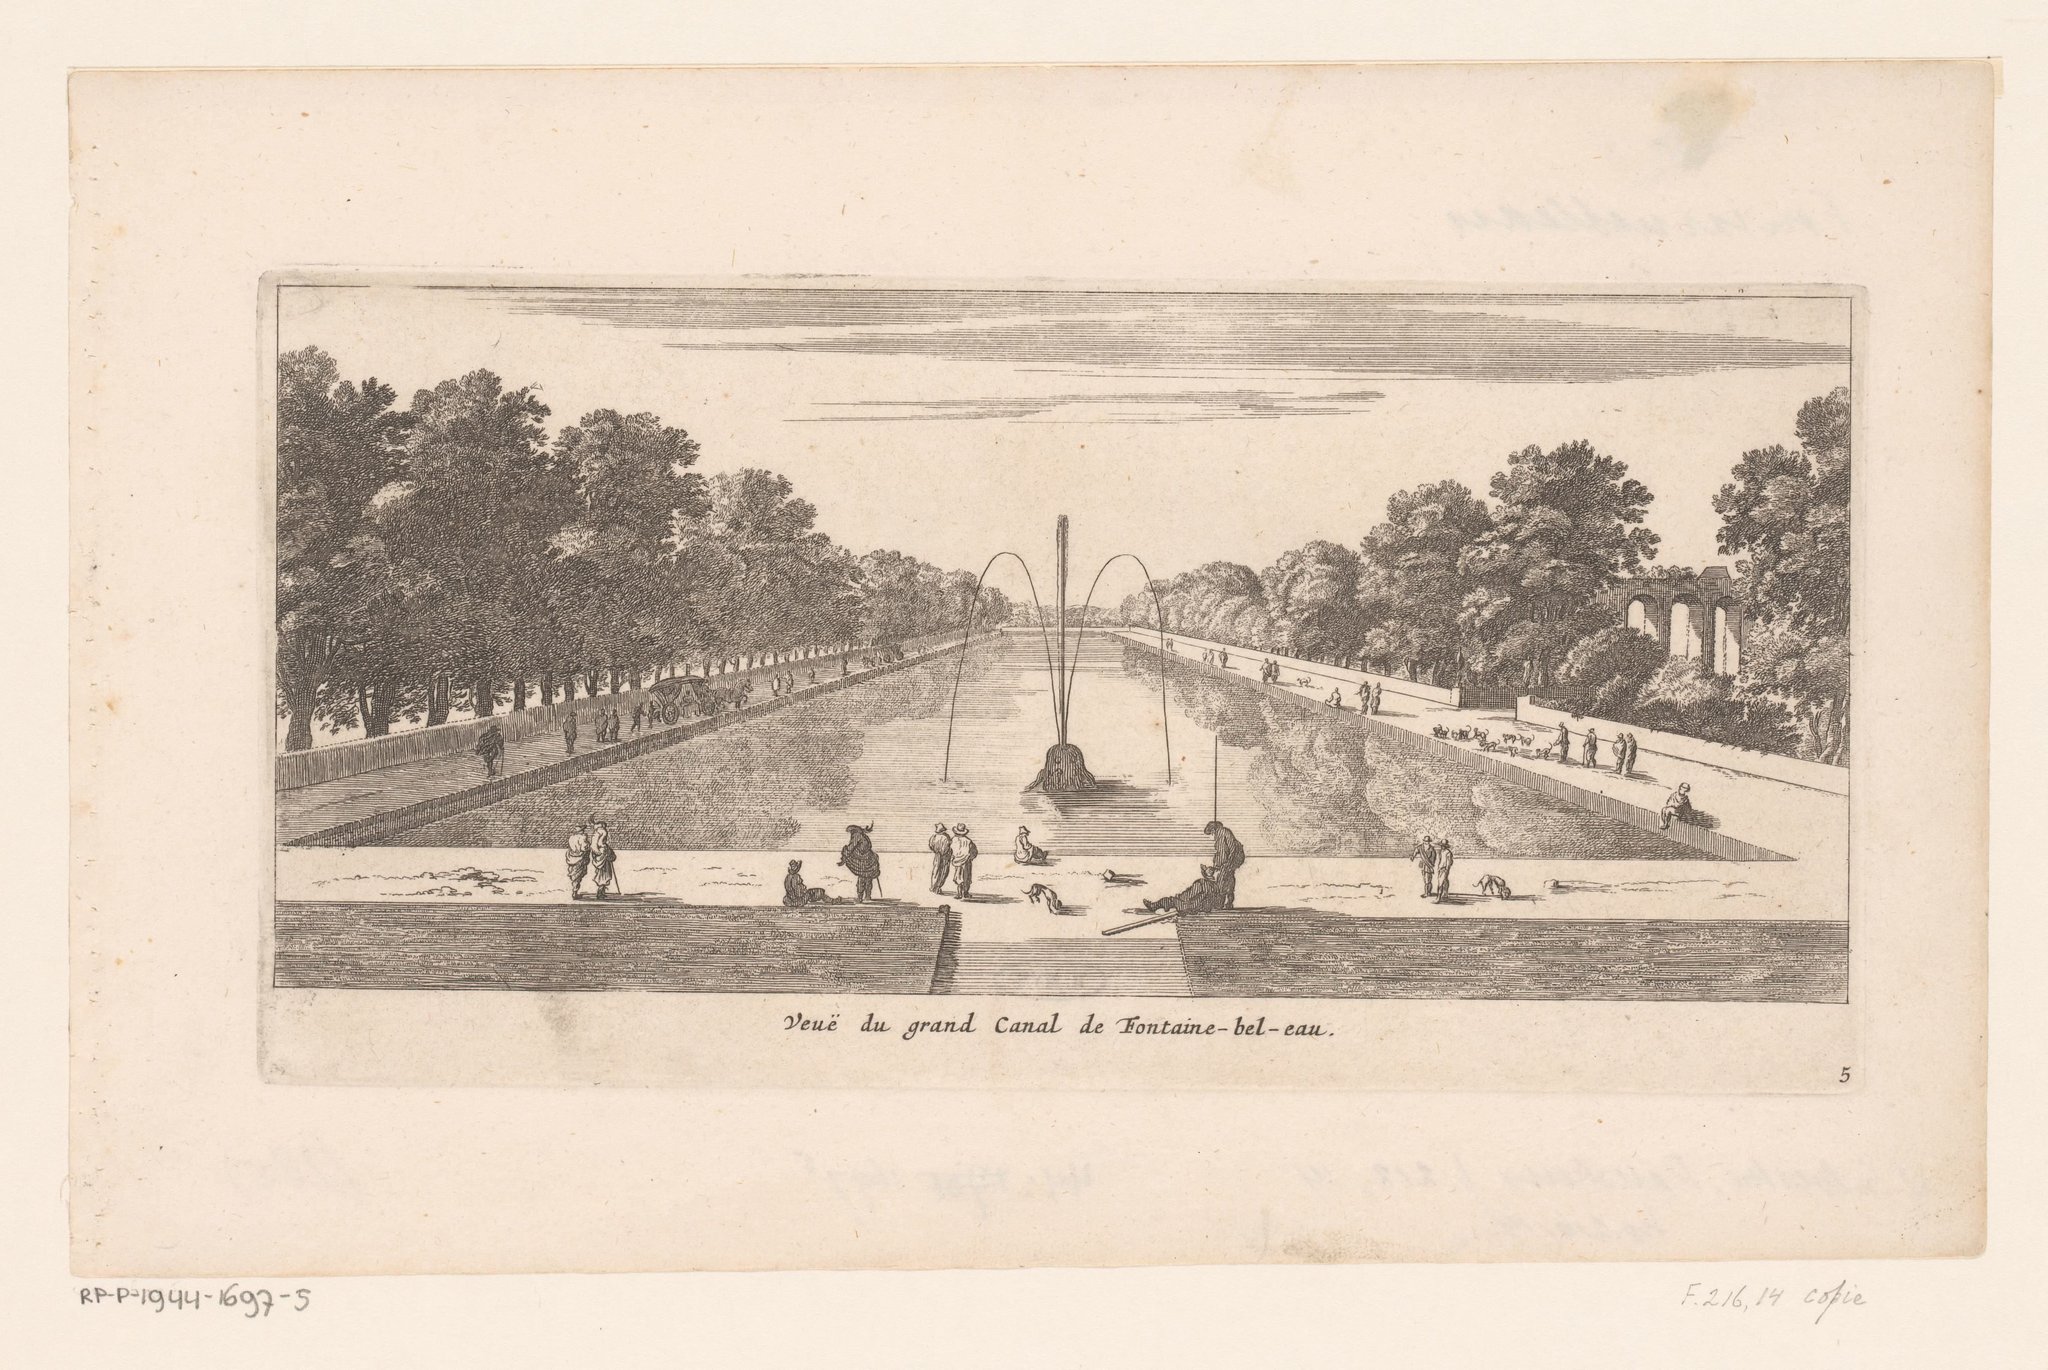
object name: print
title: Divers Veuës, et Perspectives des Fontaines et Jardins de Fontaine-bel-eau, et autres lieux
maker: Anonymous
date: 1614-1677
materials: paper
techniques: engraving, etching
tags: garden fountain, french or architectonic garden; formal garden, city-view, and landscape with man-made constructions (+ city(-scape) with figures, staffage)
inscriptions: collector's mark: Lugt 2228